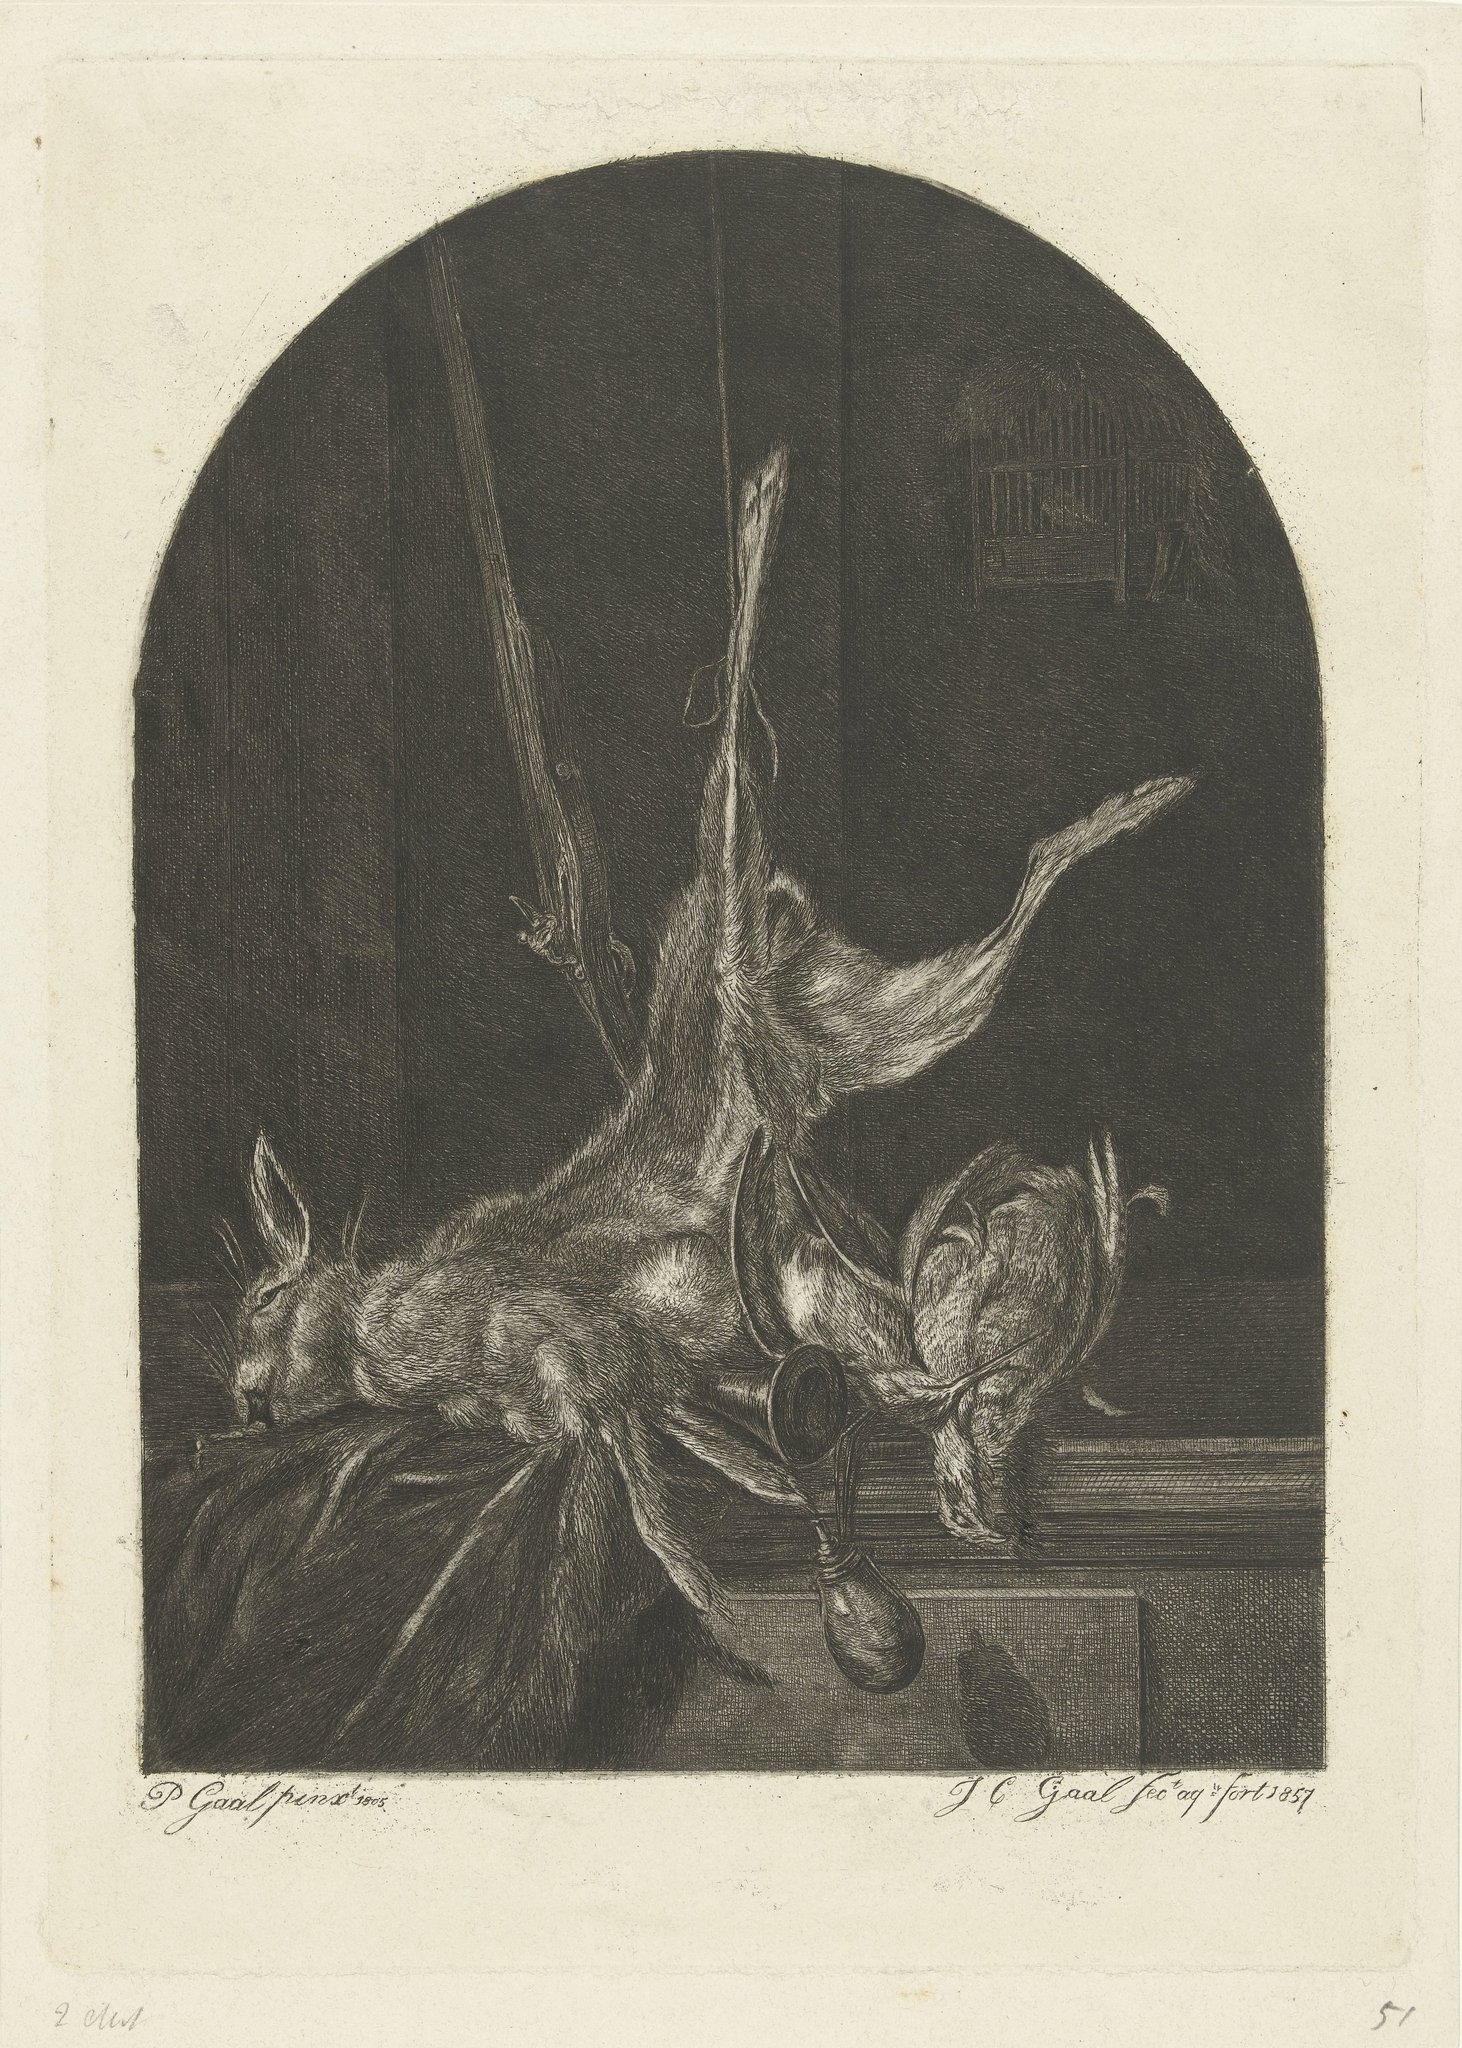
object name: print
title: Stilleven met dode haas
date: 1857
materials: paper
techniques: etching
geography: netherlands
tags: still life of miscellaneous objects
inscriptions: collector's mark: Lugt 2228